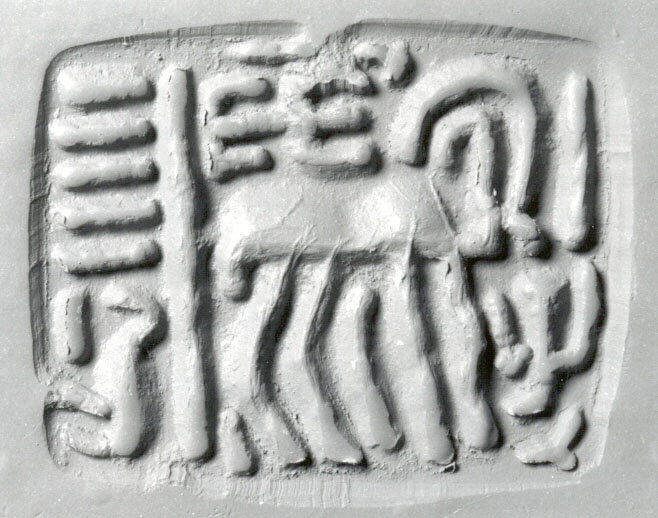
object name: stamp seal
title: Rectangular plaque seal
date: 3100-2900 BCE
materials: mineral, stone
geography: iran or mesopotamia